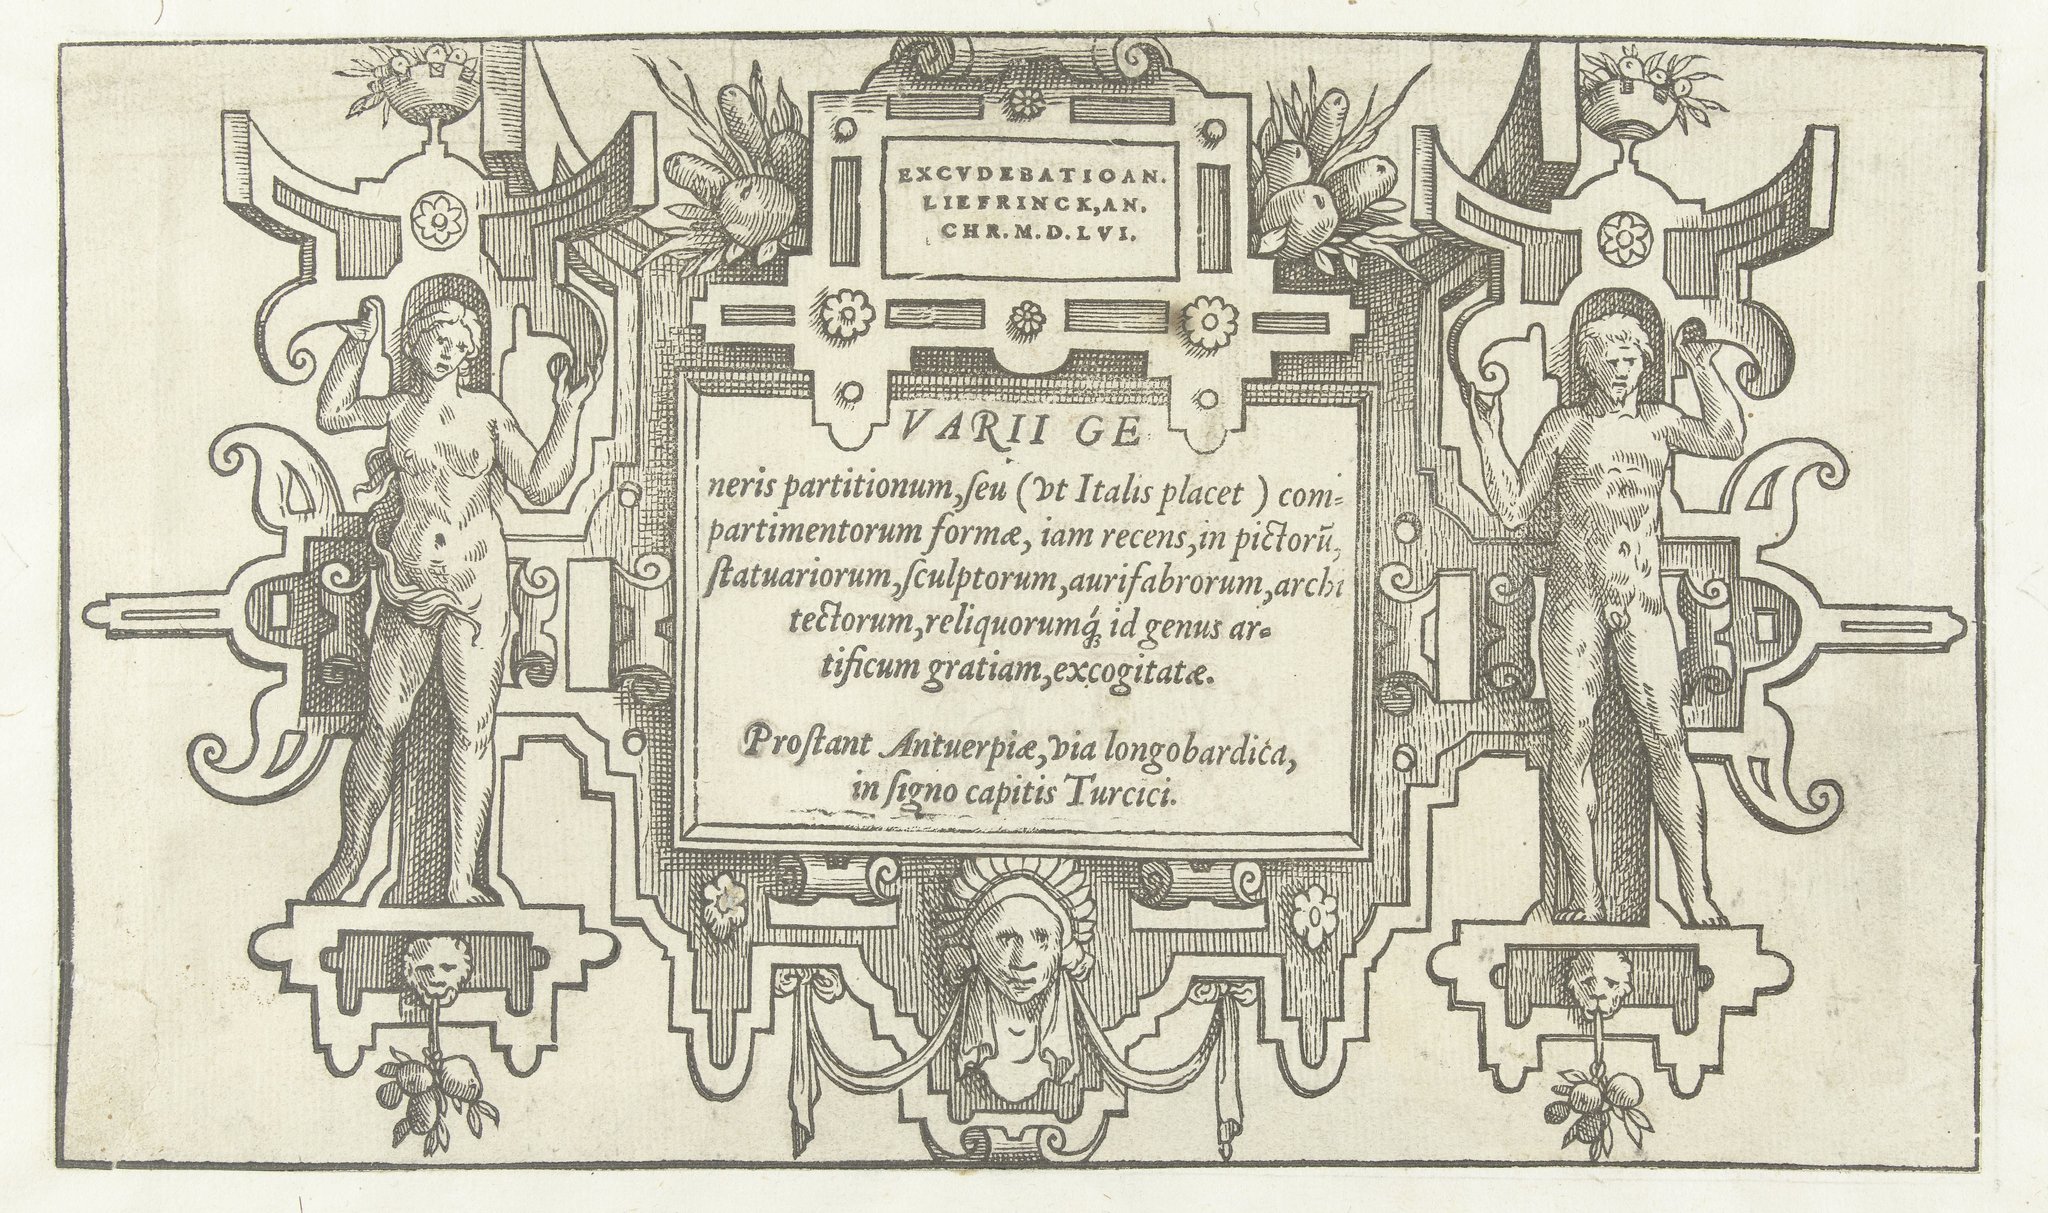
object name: print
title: Titel en 15 bladen van de reeks: Varii generis partitionum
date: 1556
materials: paper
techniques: woodcut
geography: antwerp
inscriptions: number: ‘109’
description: Links staat een vrouw, rechts een man. Blad hoort bij 15 bladen met titelblad afkomstig uit een serie van 24 bladen met cartouches met citaten van klassieke schrijvers in een omlijsting van rolwerk met grotesken, figuren, dieren, guirlandes en mascarons. Houtsneden.